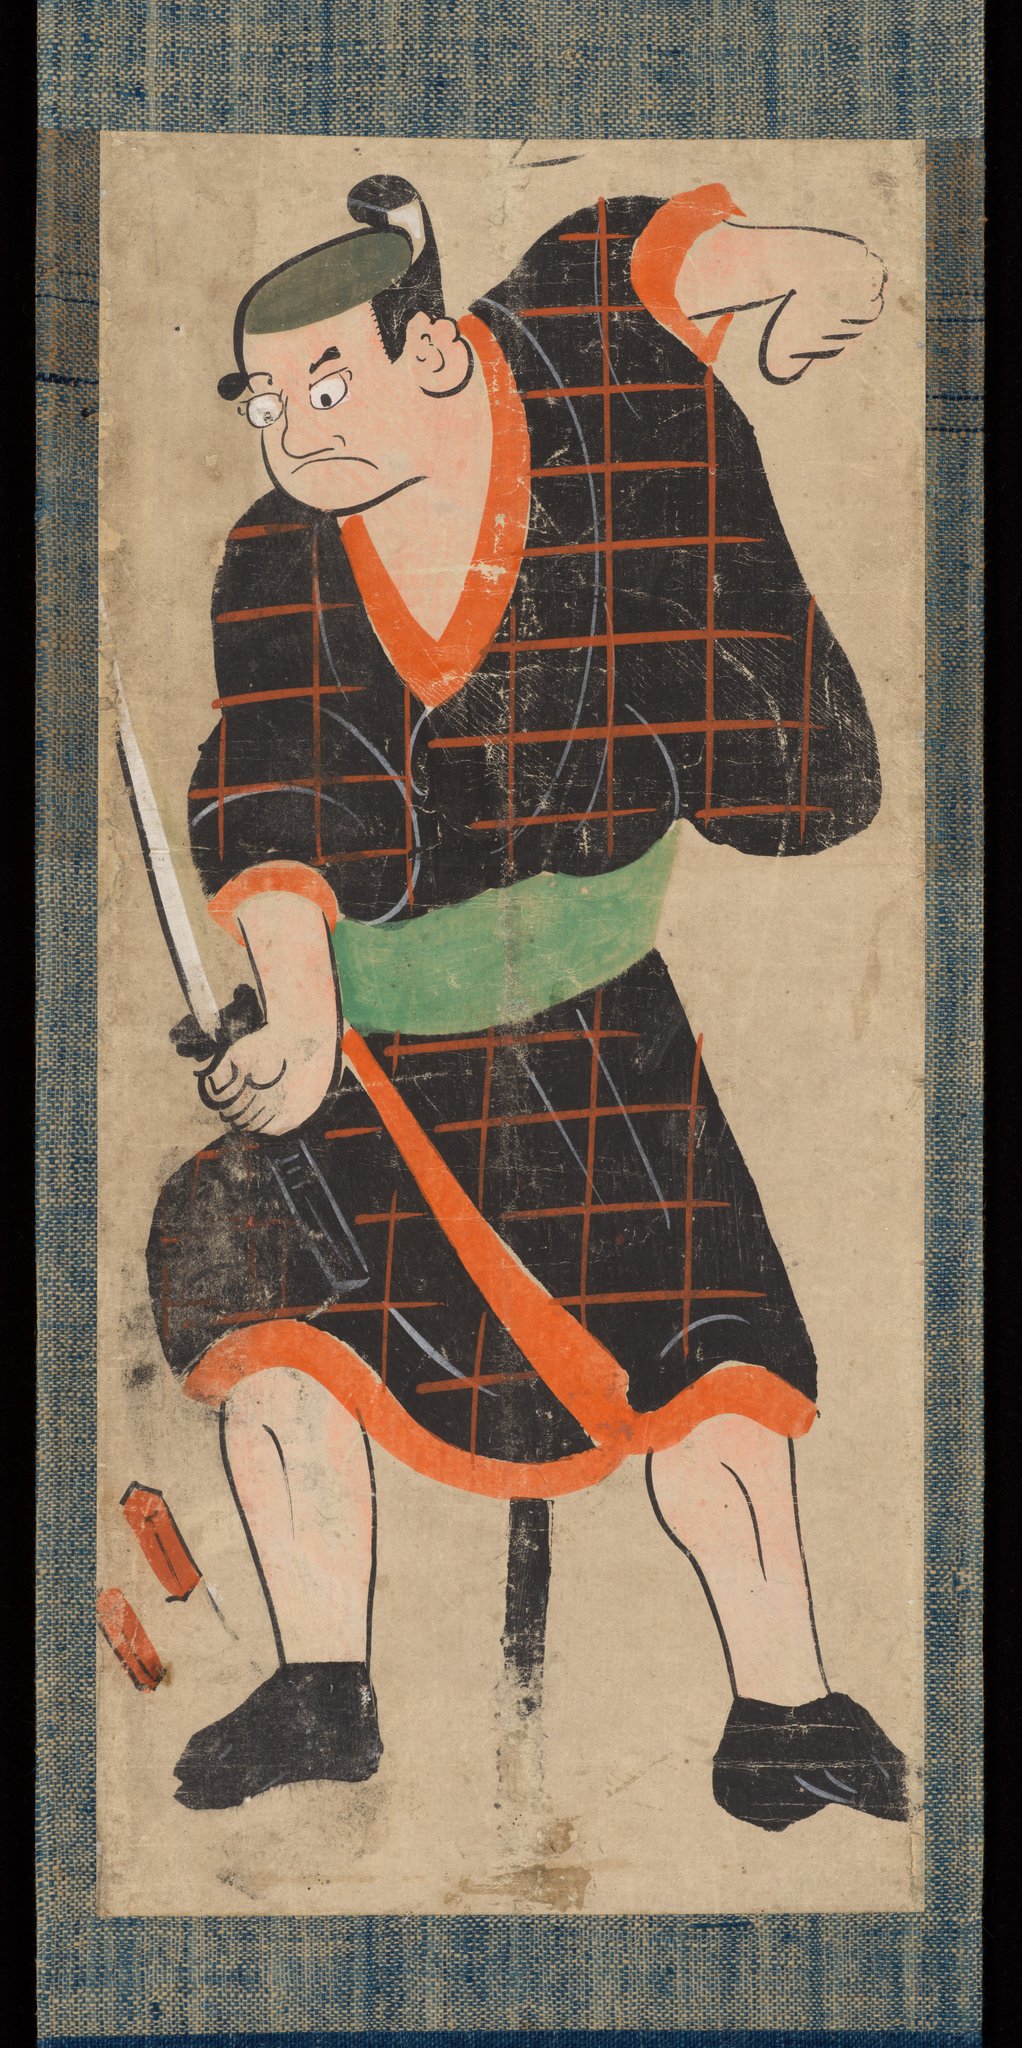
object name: hanging scroll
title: Ōtsu-e of Kabuki Actor Playing Hotei Ichiemon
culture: japanese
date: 1701-1733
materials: paper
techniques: hand coloring, woodblock print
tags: men,actors